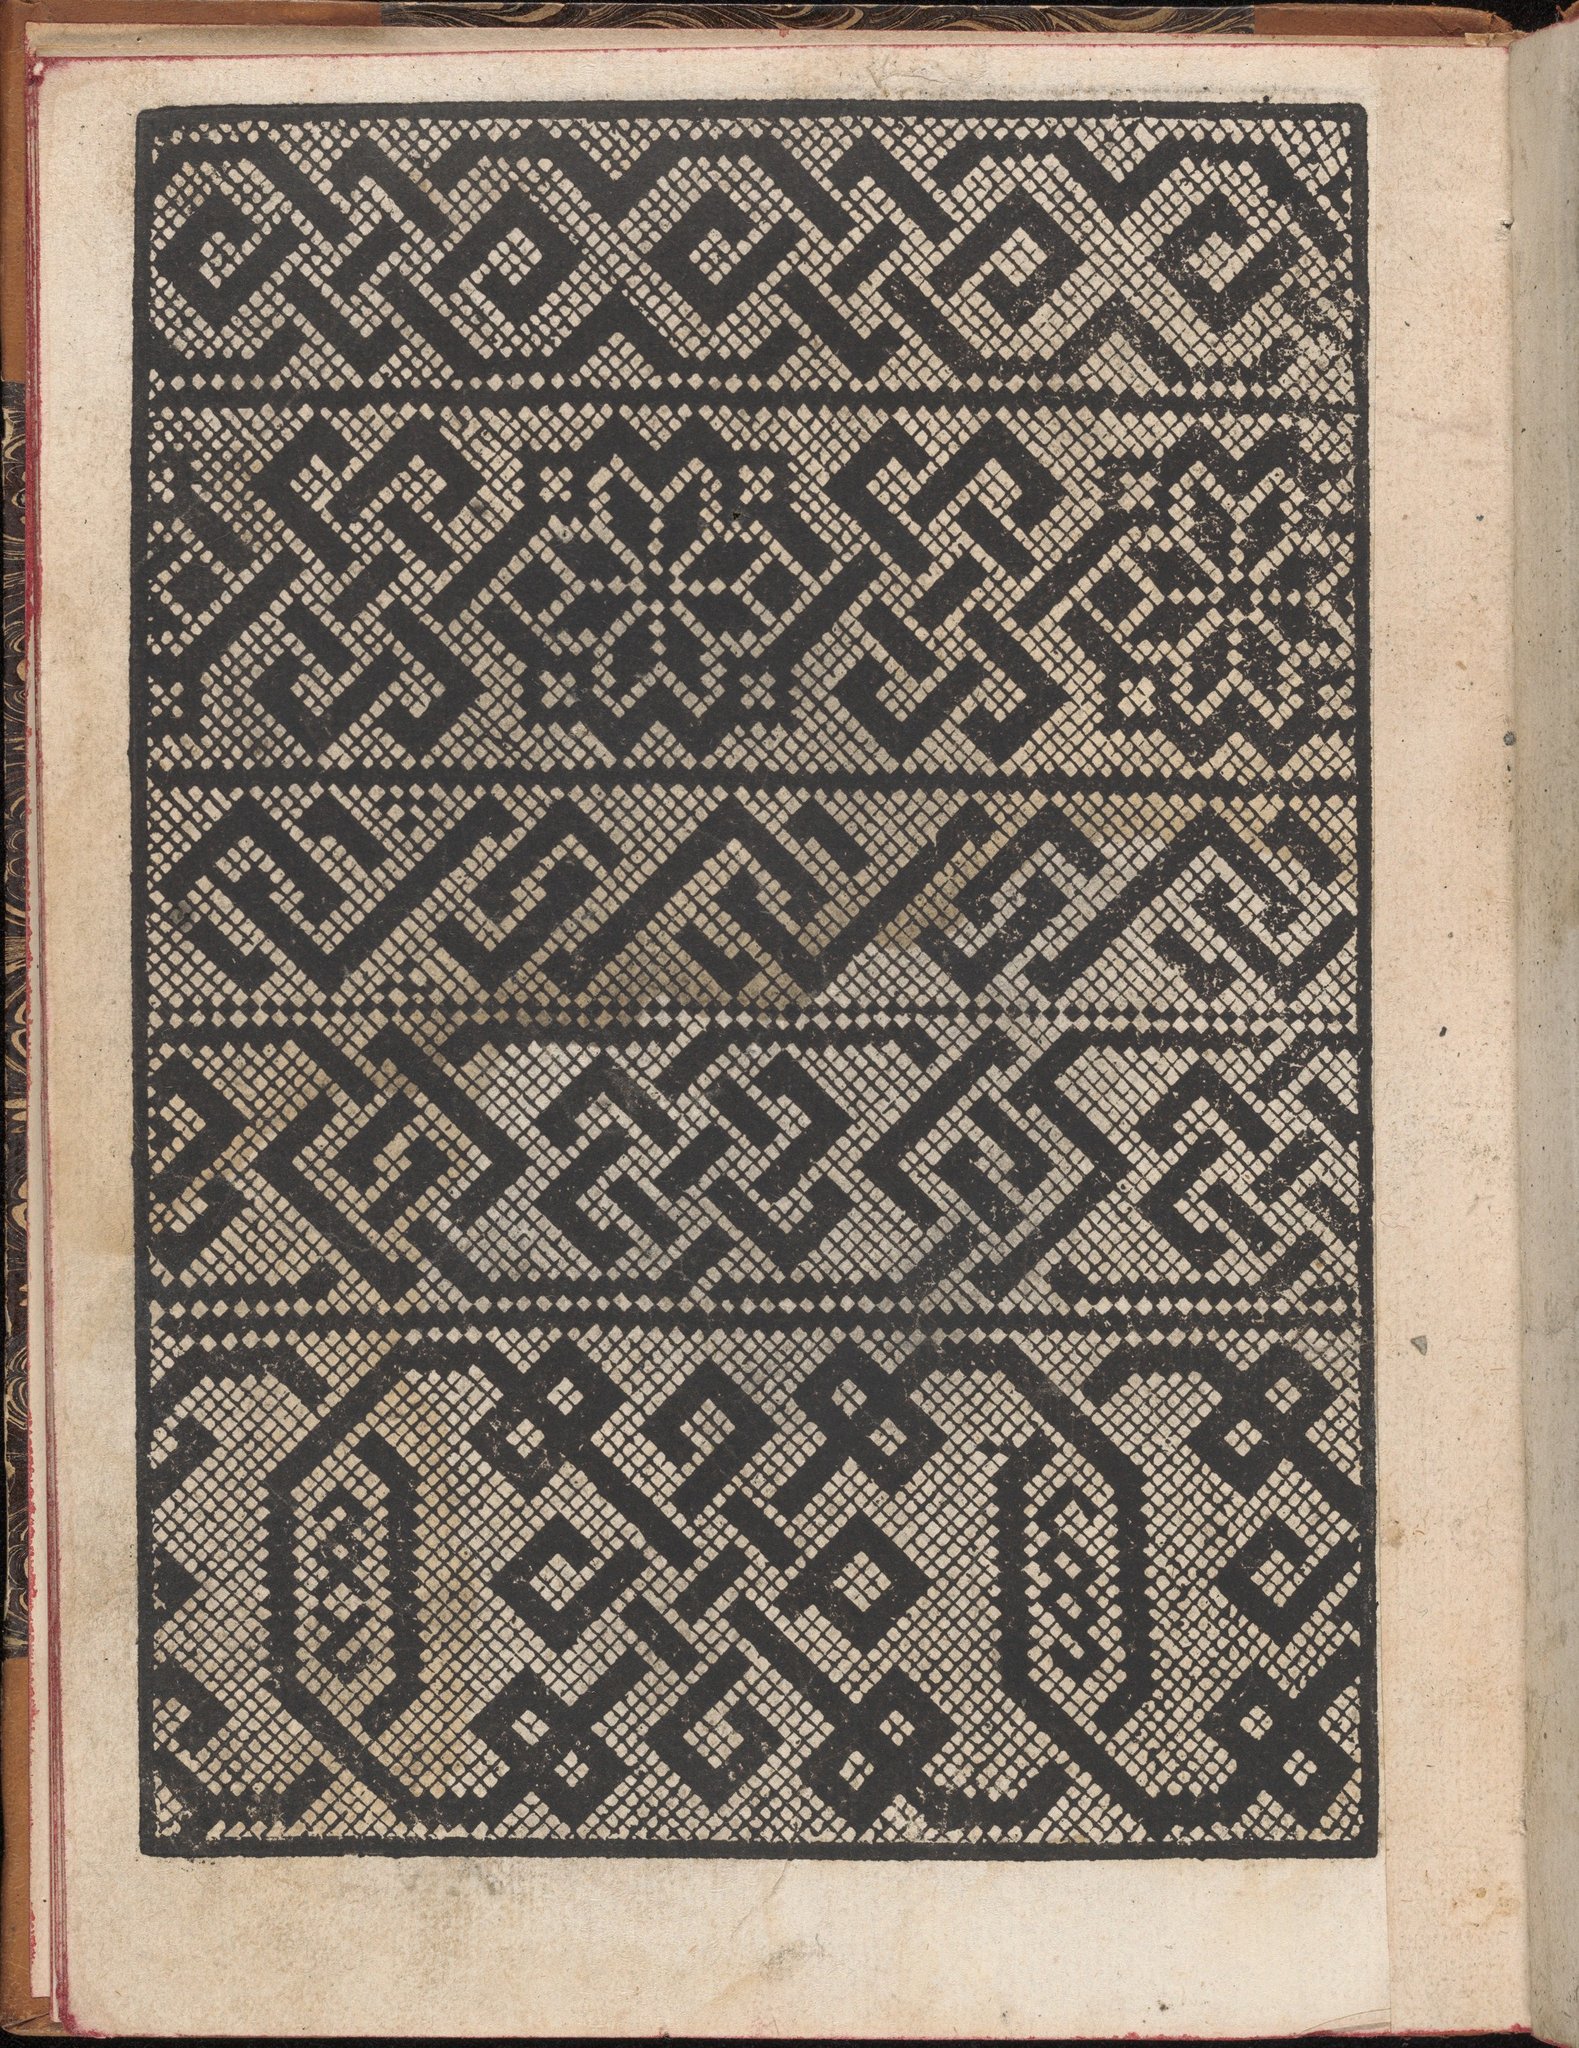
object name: book print ornament architecture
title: Spechio di pensieri delle belle et Virtudiose donne, page 4 (verso)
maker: matteo pagano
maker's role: publisher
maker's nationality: italian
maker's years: 1515-1588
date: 1546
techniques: woodcut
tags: flowers